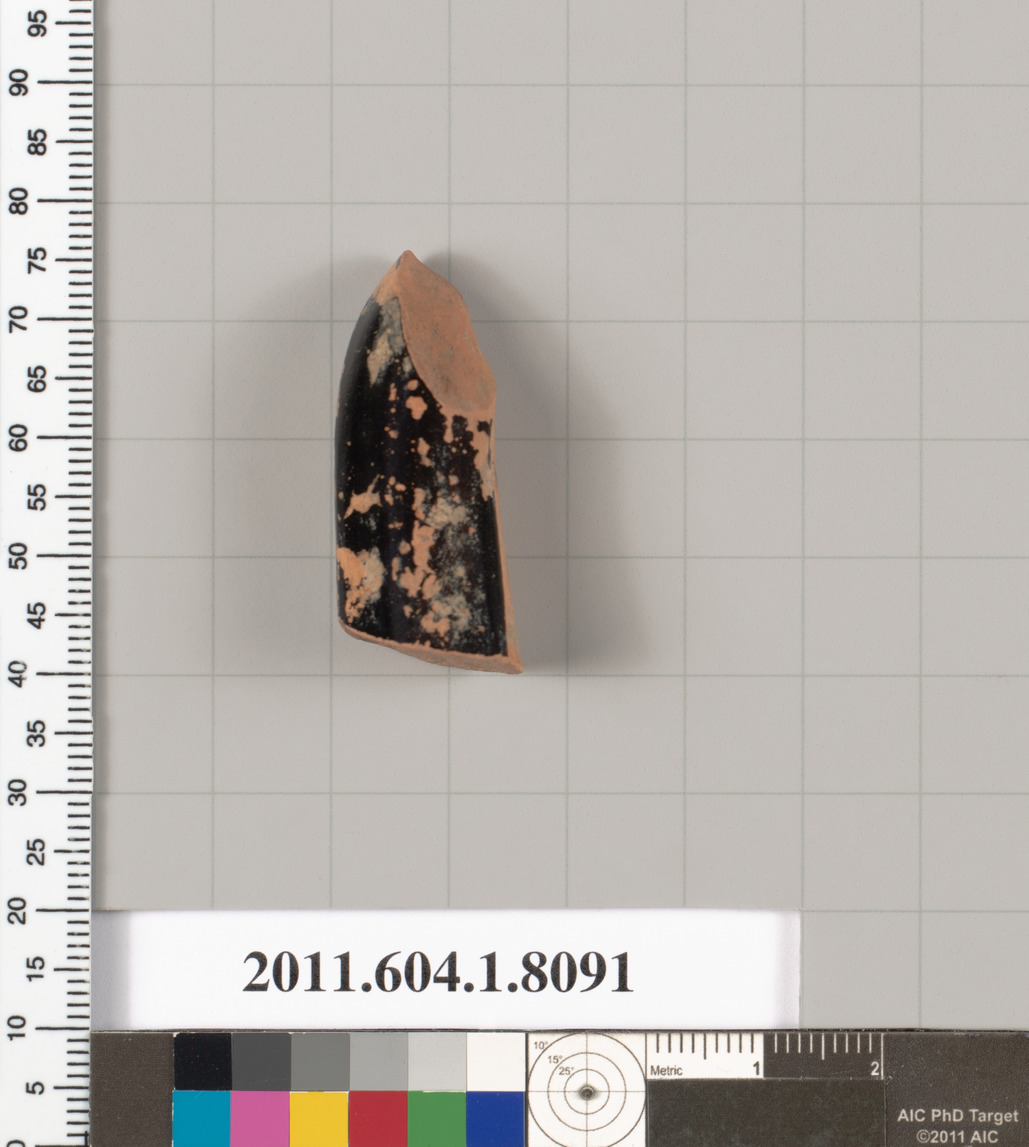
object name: kylix fragment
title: Terracotta fragment of a kylix (drinking cup)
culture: greek, attic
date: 510-500 BCE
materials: terracotta